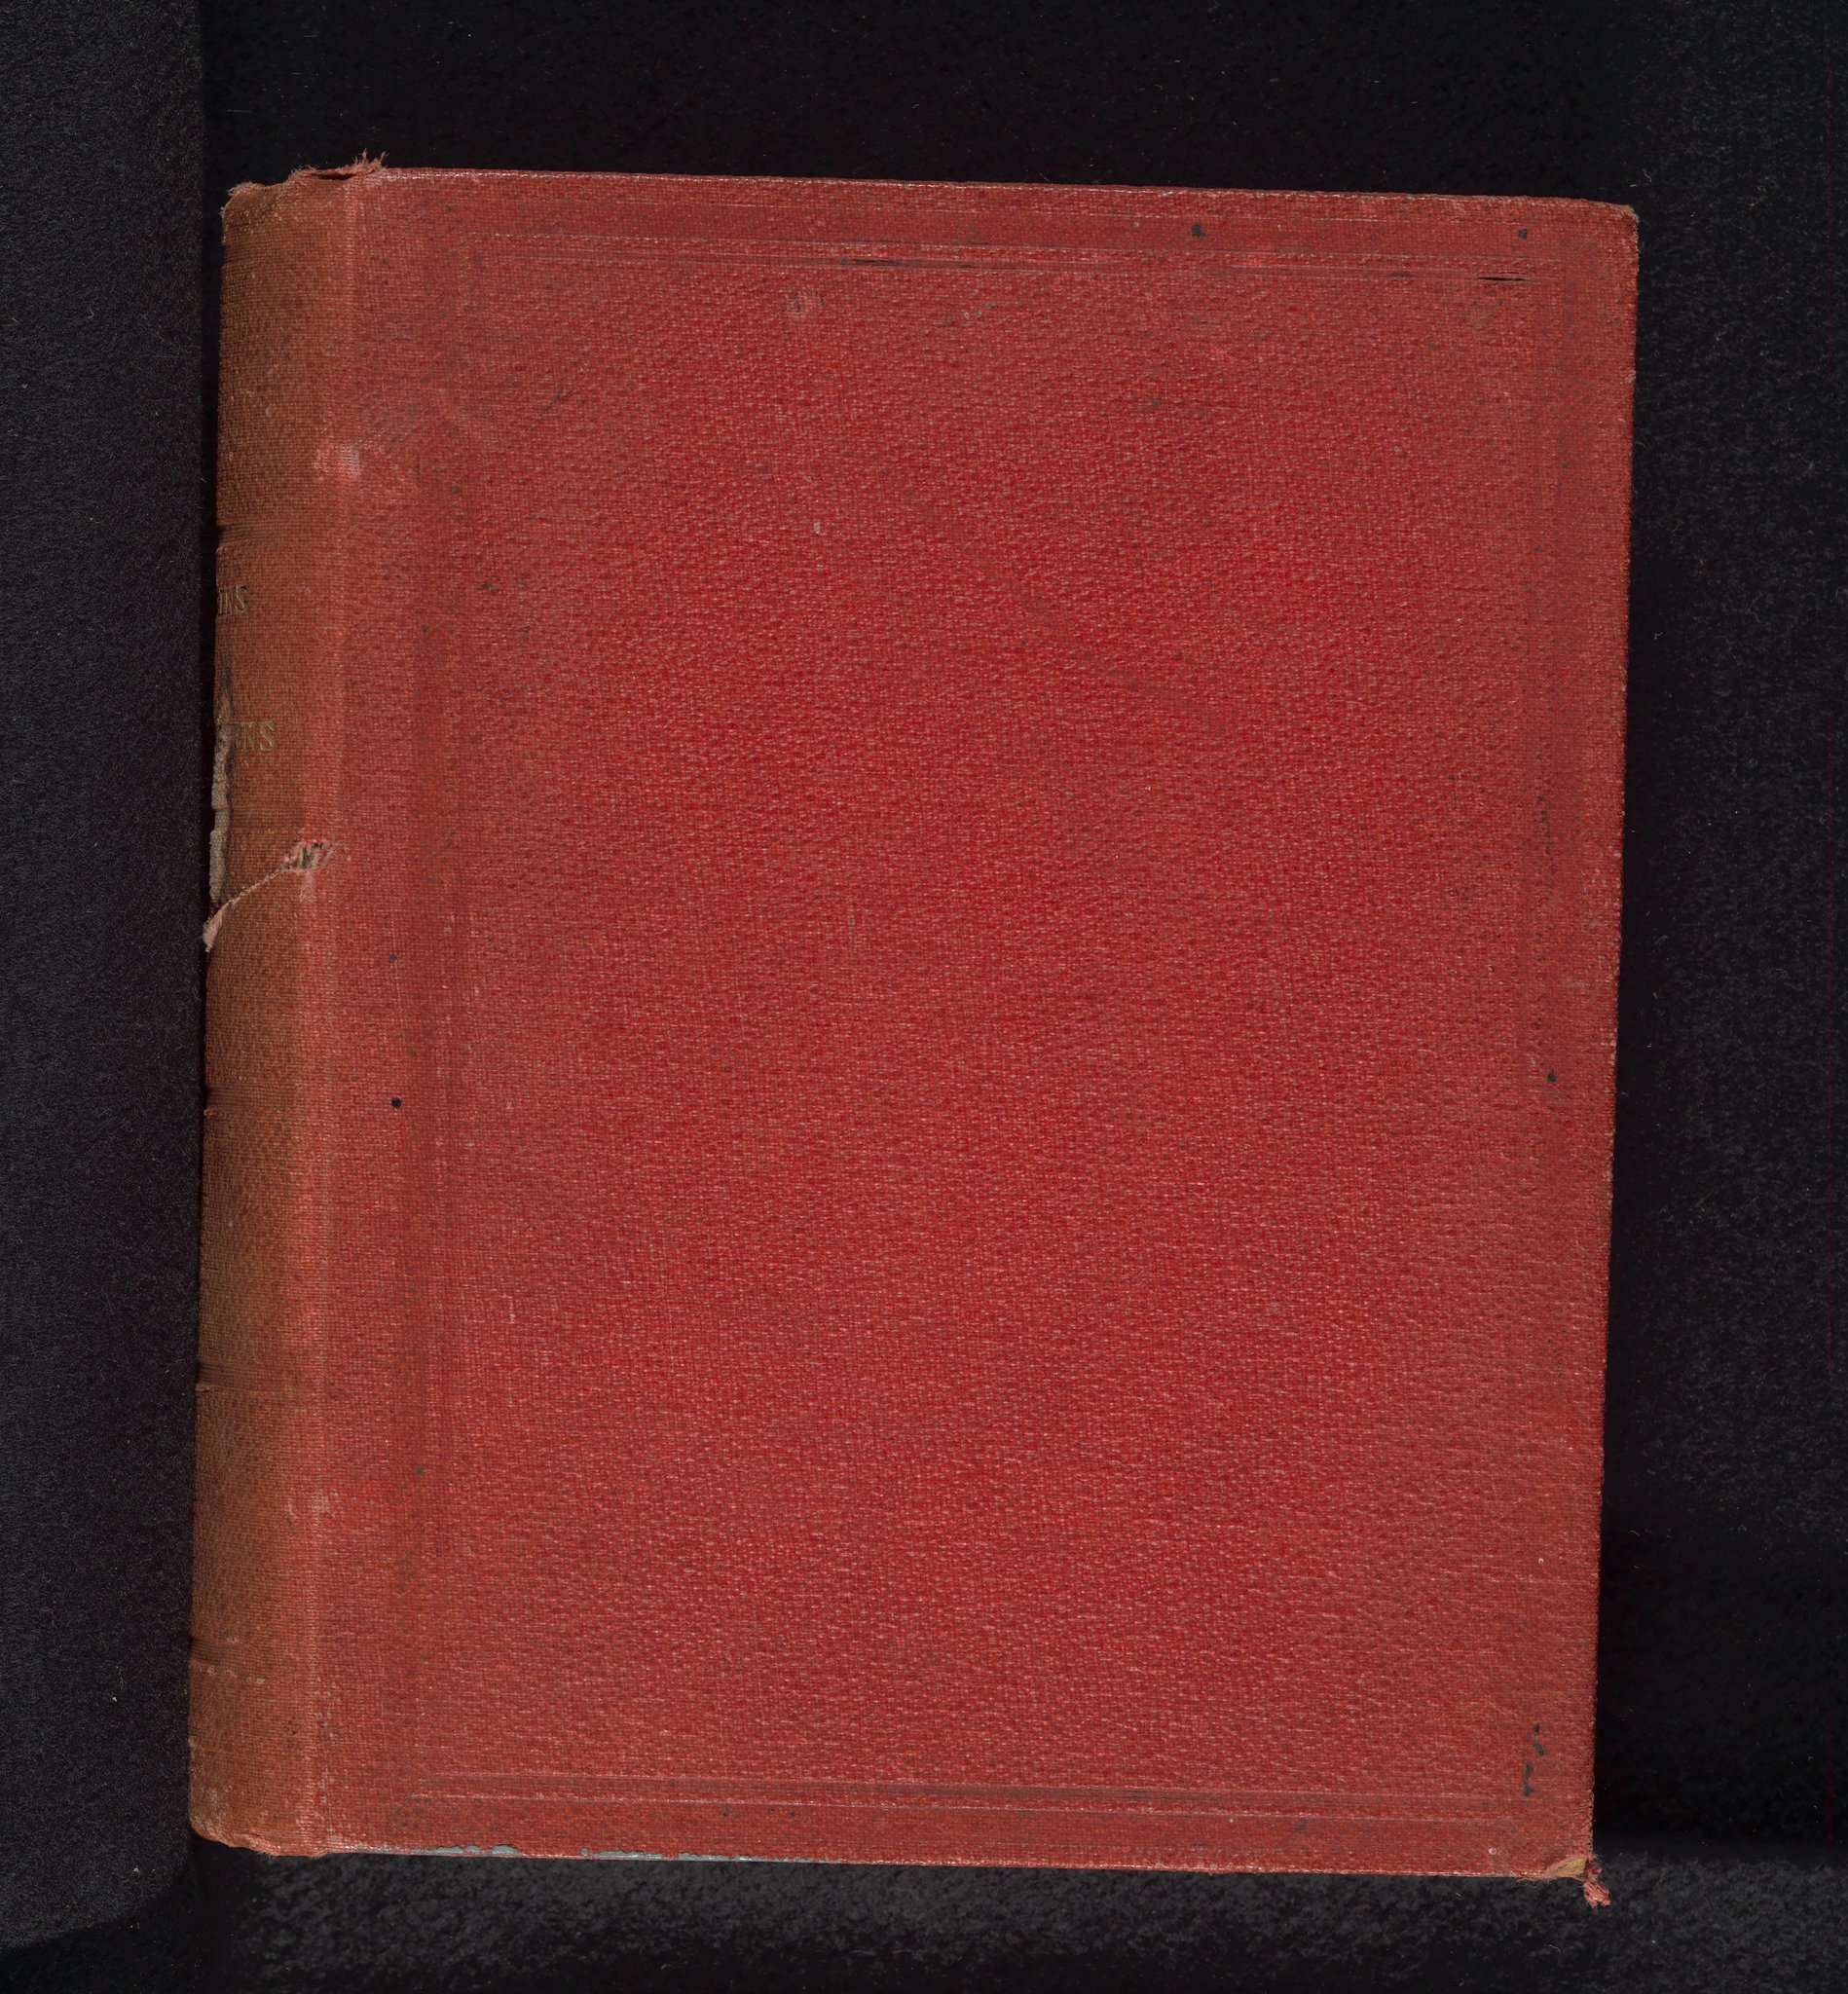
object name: book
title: Médecins chirurgiens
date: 1876-1879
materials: cardboard, paper, photographic support, textile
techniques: albumen print, photograph, decorated paper, printing, woodburytype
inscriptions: annotation: ‘700/ 47pl.’